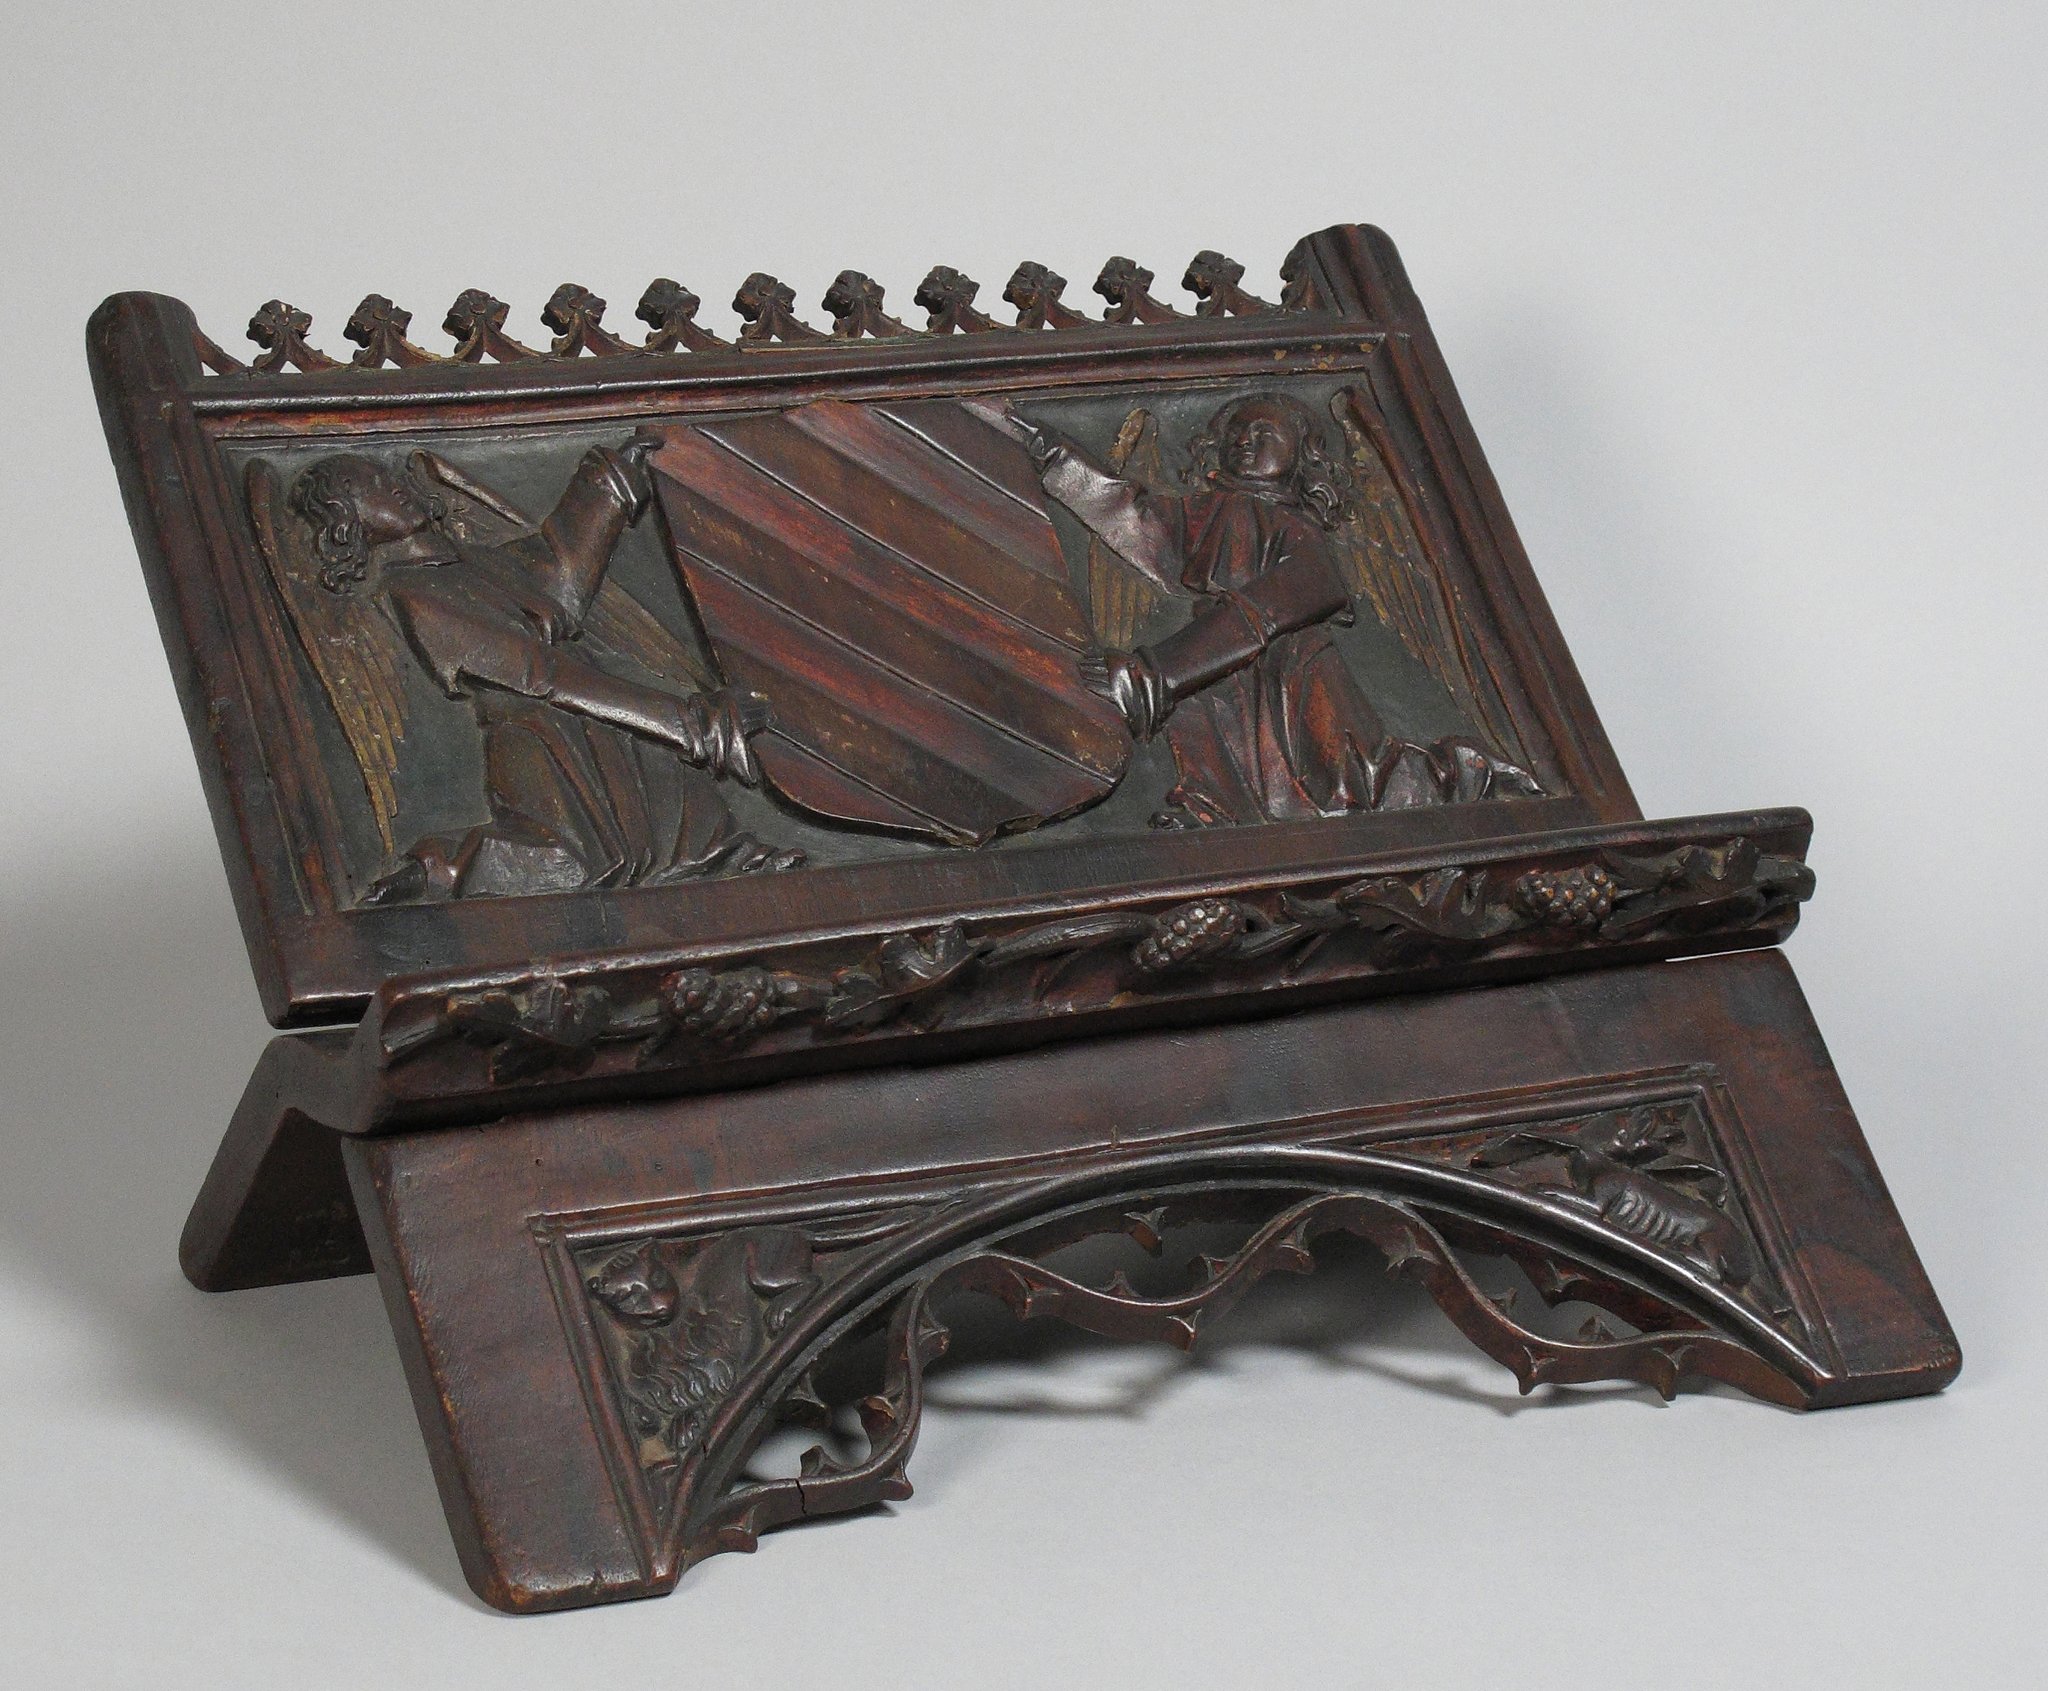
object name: folding lectern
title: Lectern, Folding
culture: spanish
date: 1401-1500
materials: wood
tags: mythical creatures,angels